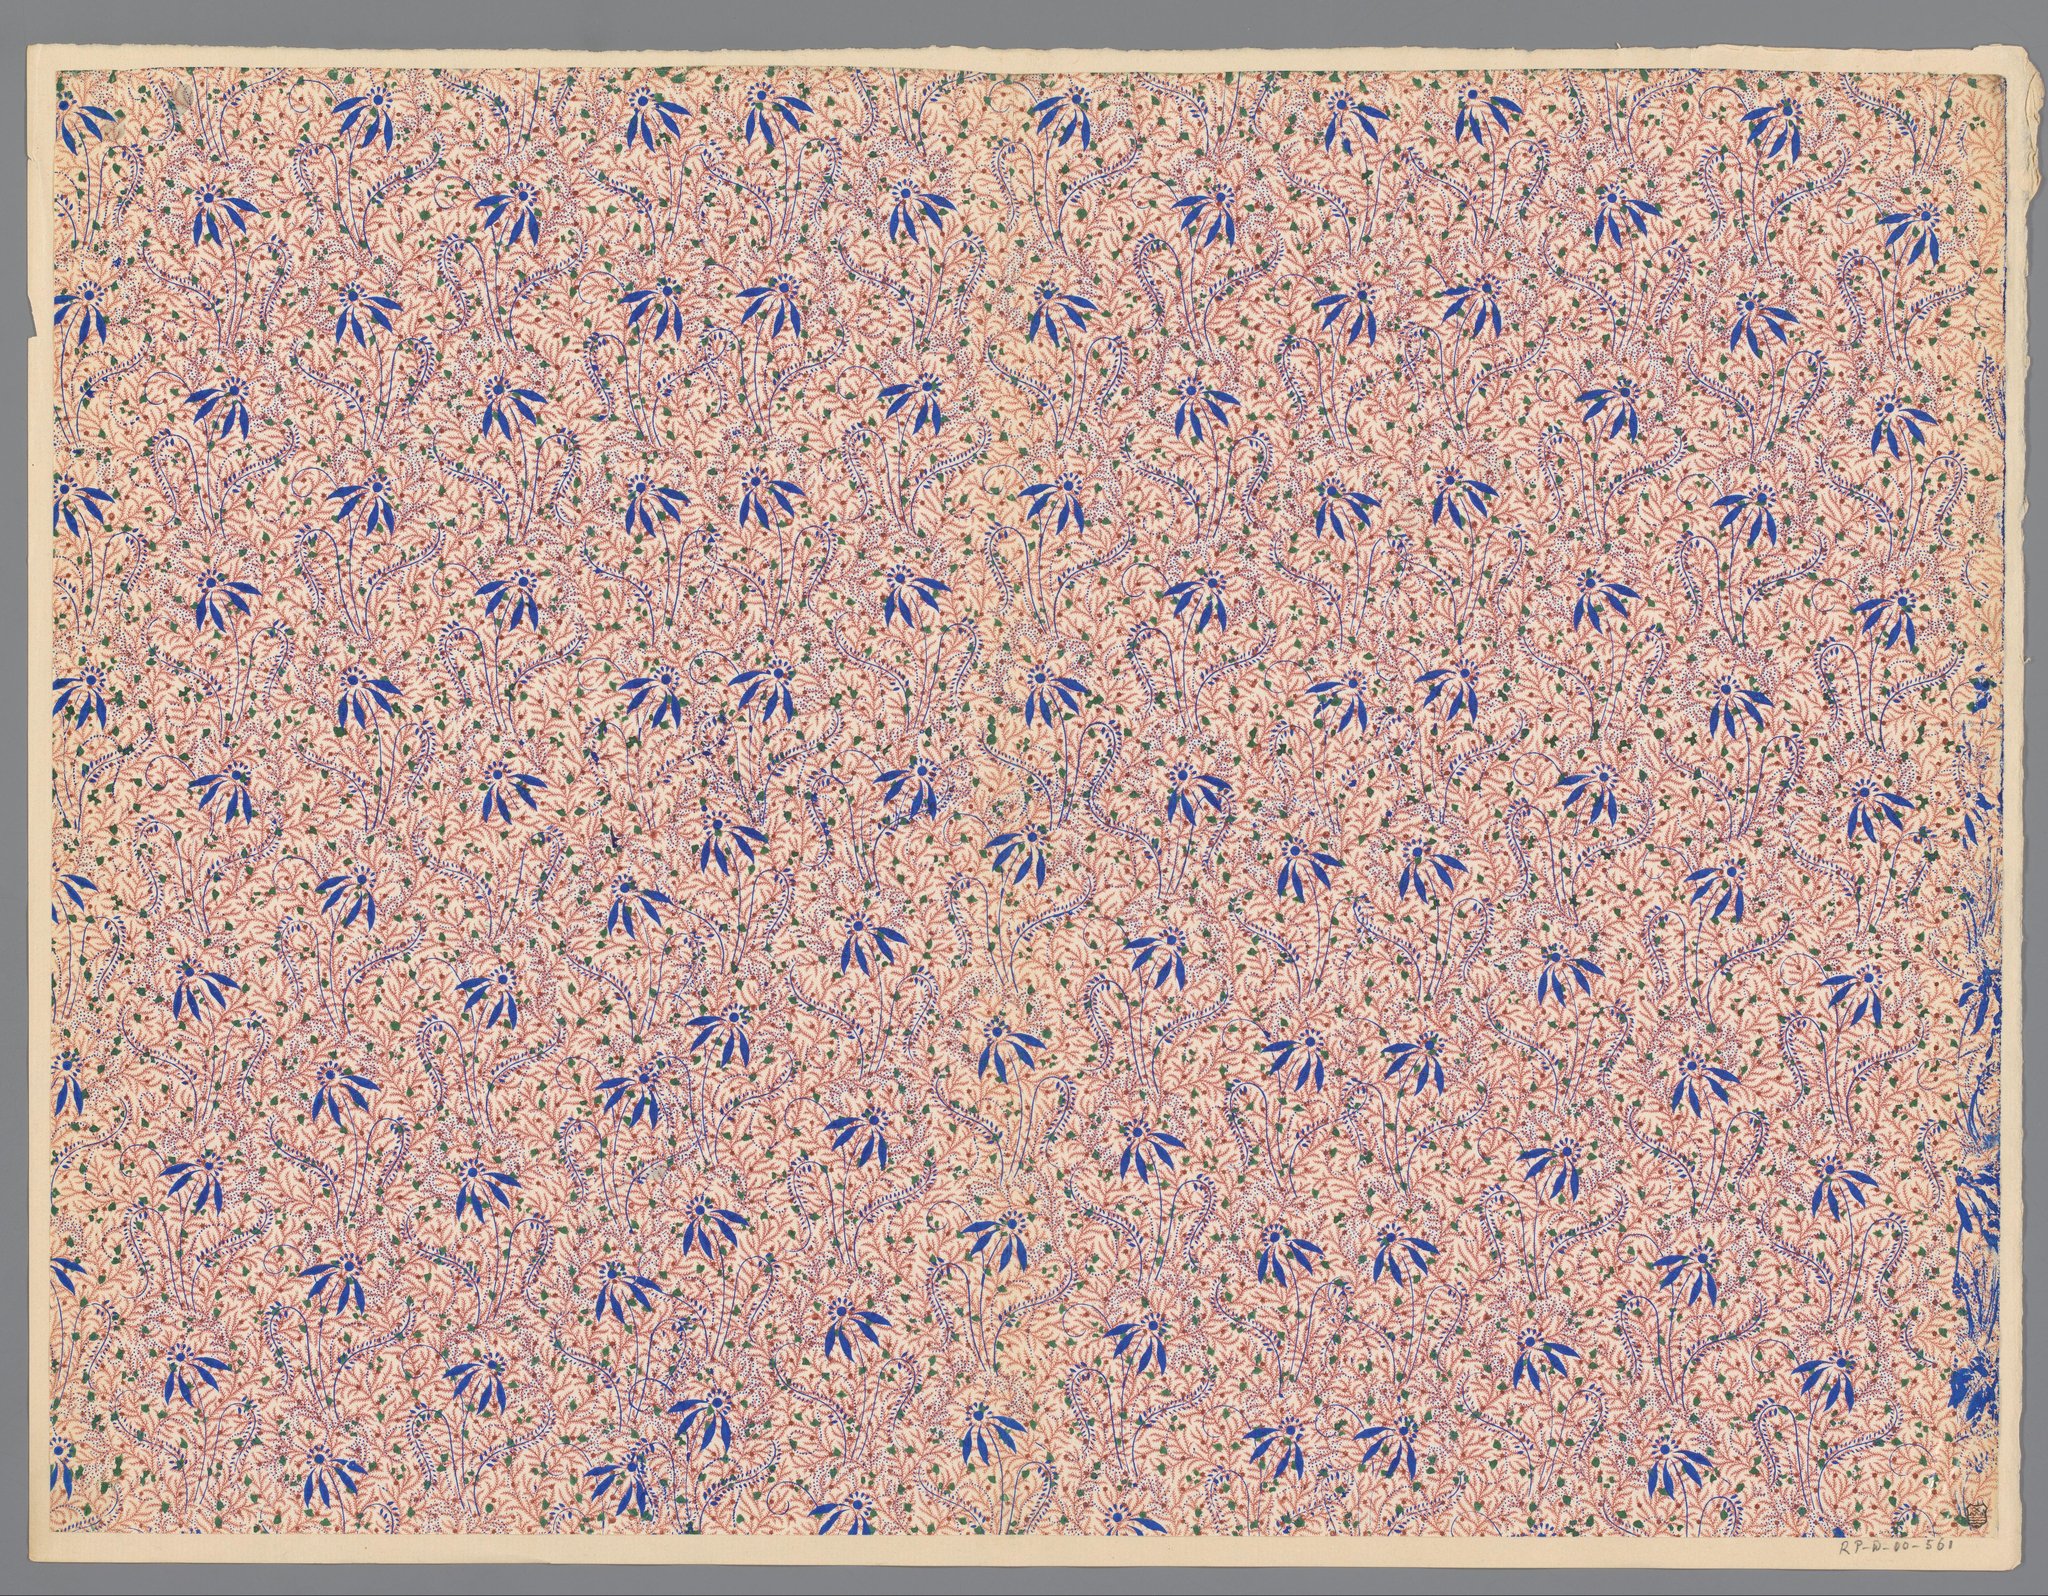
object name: printed paper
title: Blad met strooipatroon van bloemen en stippen over een motief van fijnvertakte ranken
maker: Anonymous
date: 1800-1900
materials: paper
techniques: printing block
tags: ornament derived from plant forms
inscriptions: collector's mark: Lugt 2760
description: Blad met strooipatroon van bloemen en stippen over een motief van fijnvertakte ranken.